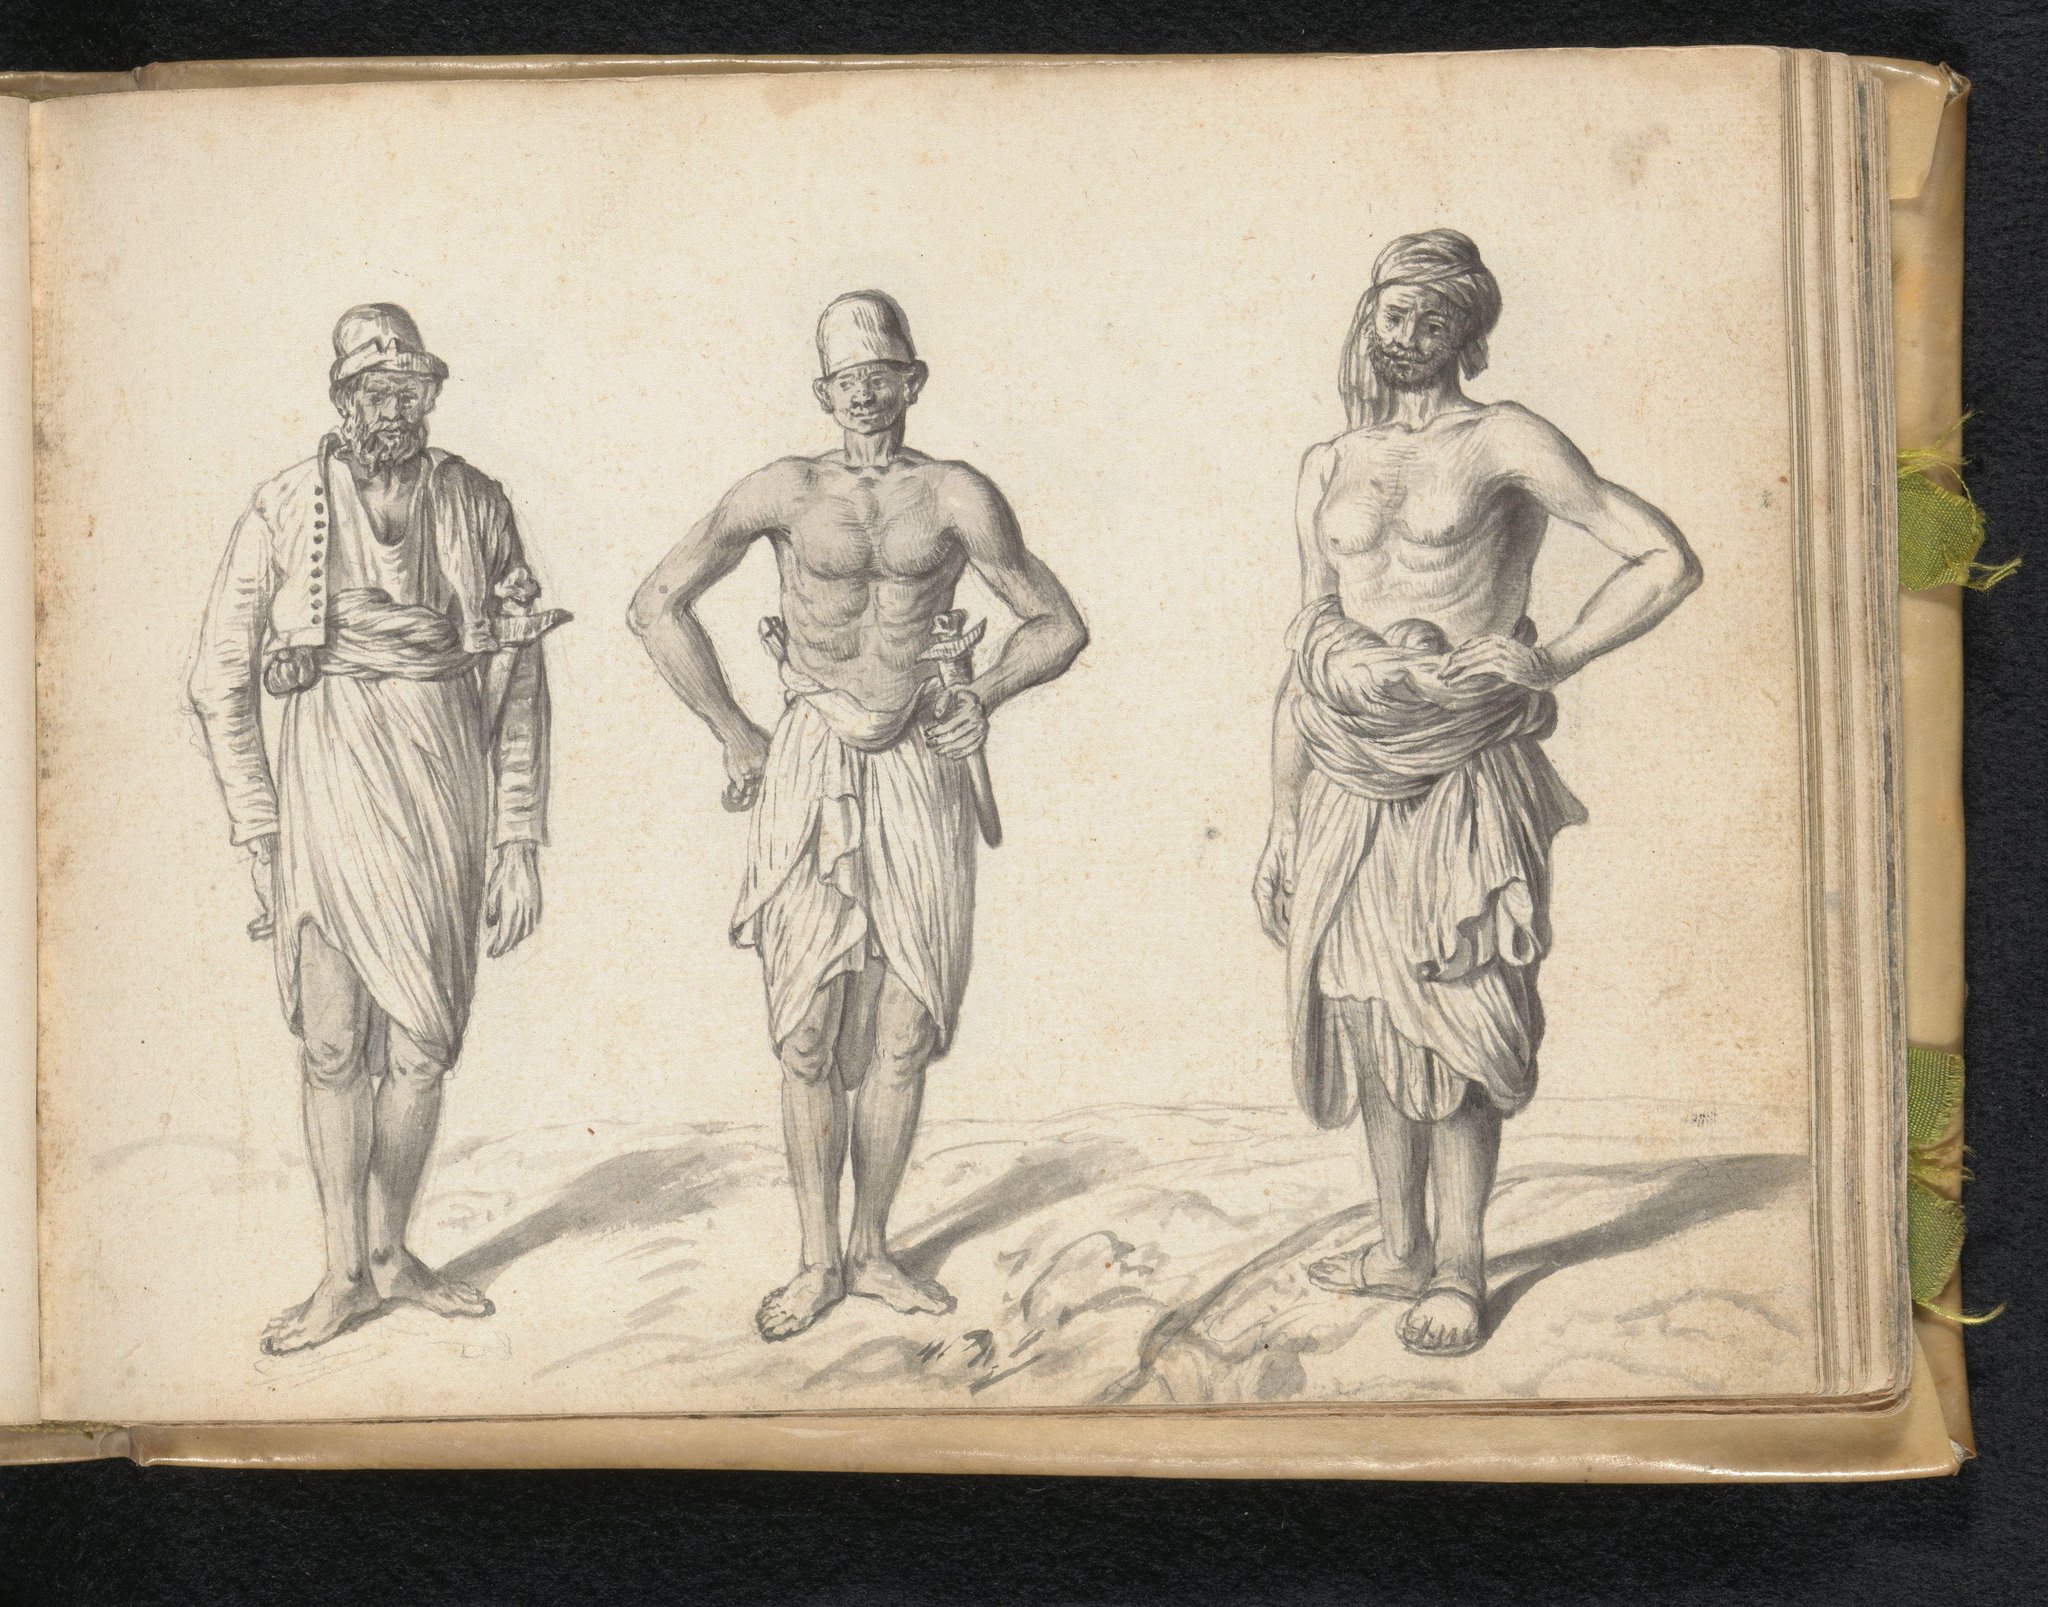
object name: sketchbook leaf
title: Two Sinhalese soldiers and a labourer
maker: esaias boursse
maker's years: 1631-1672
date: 1662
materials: ink, paper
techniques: brush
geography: sri lanka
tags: asiatic races and peoples (with name), 41d232(...) skirt (lungi), head-gear (with name), clothing for the upper part of the body (with name), hacking and thrusting weapons (with name), asiatic races and peoples: indians, sri lanka